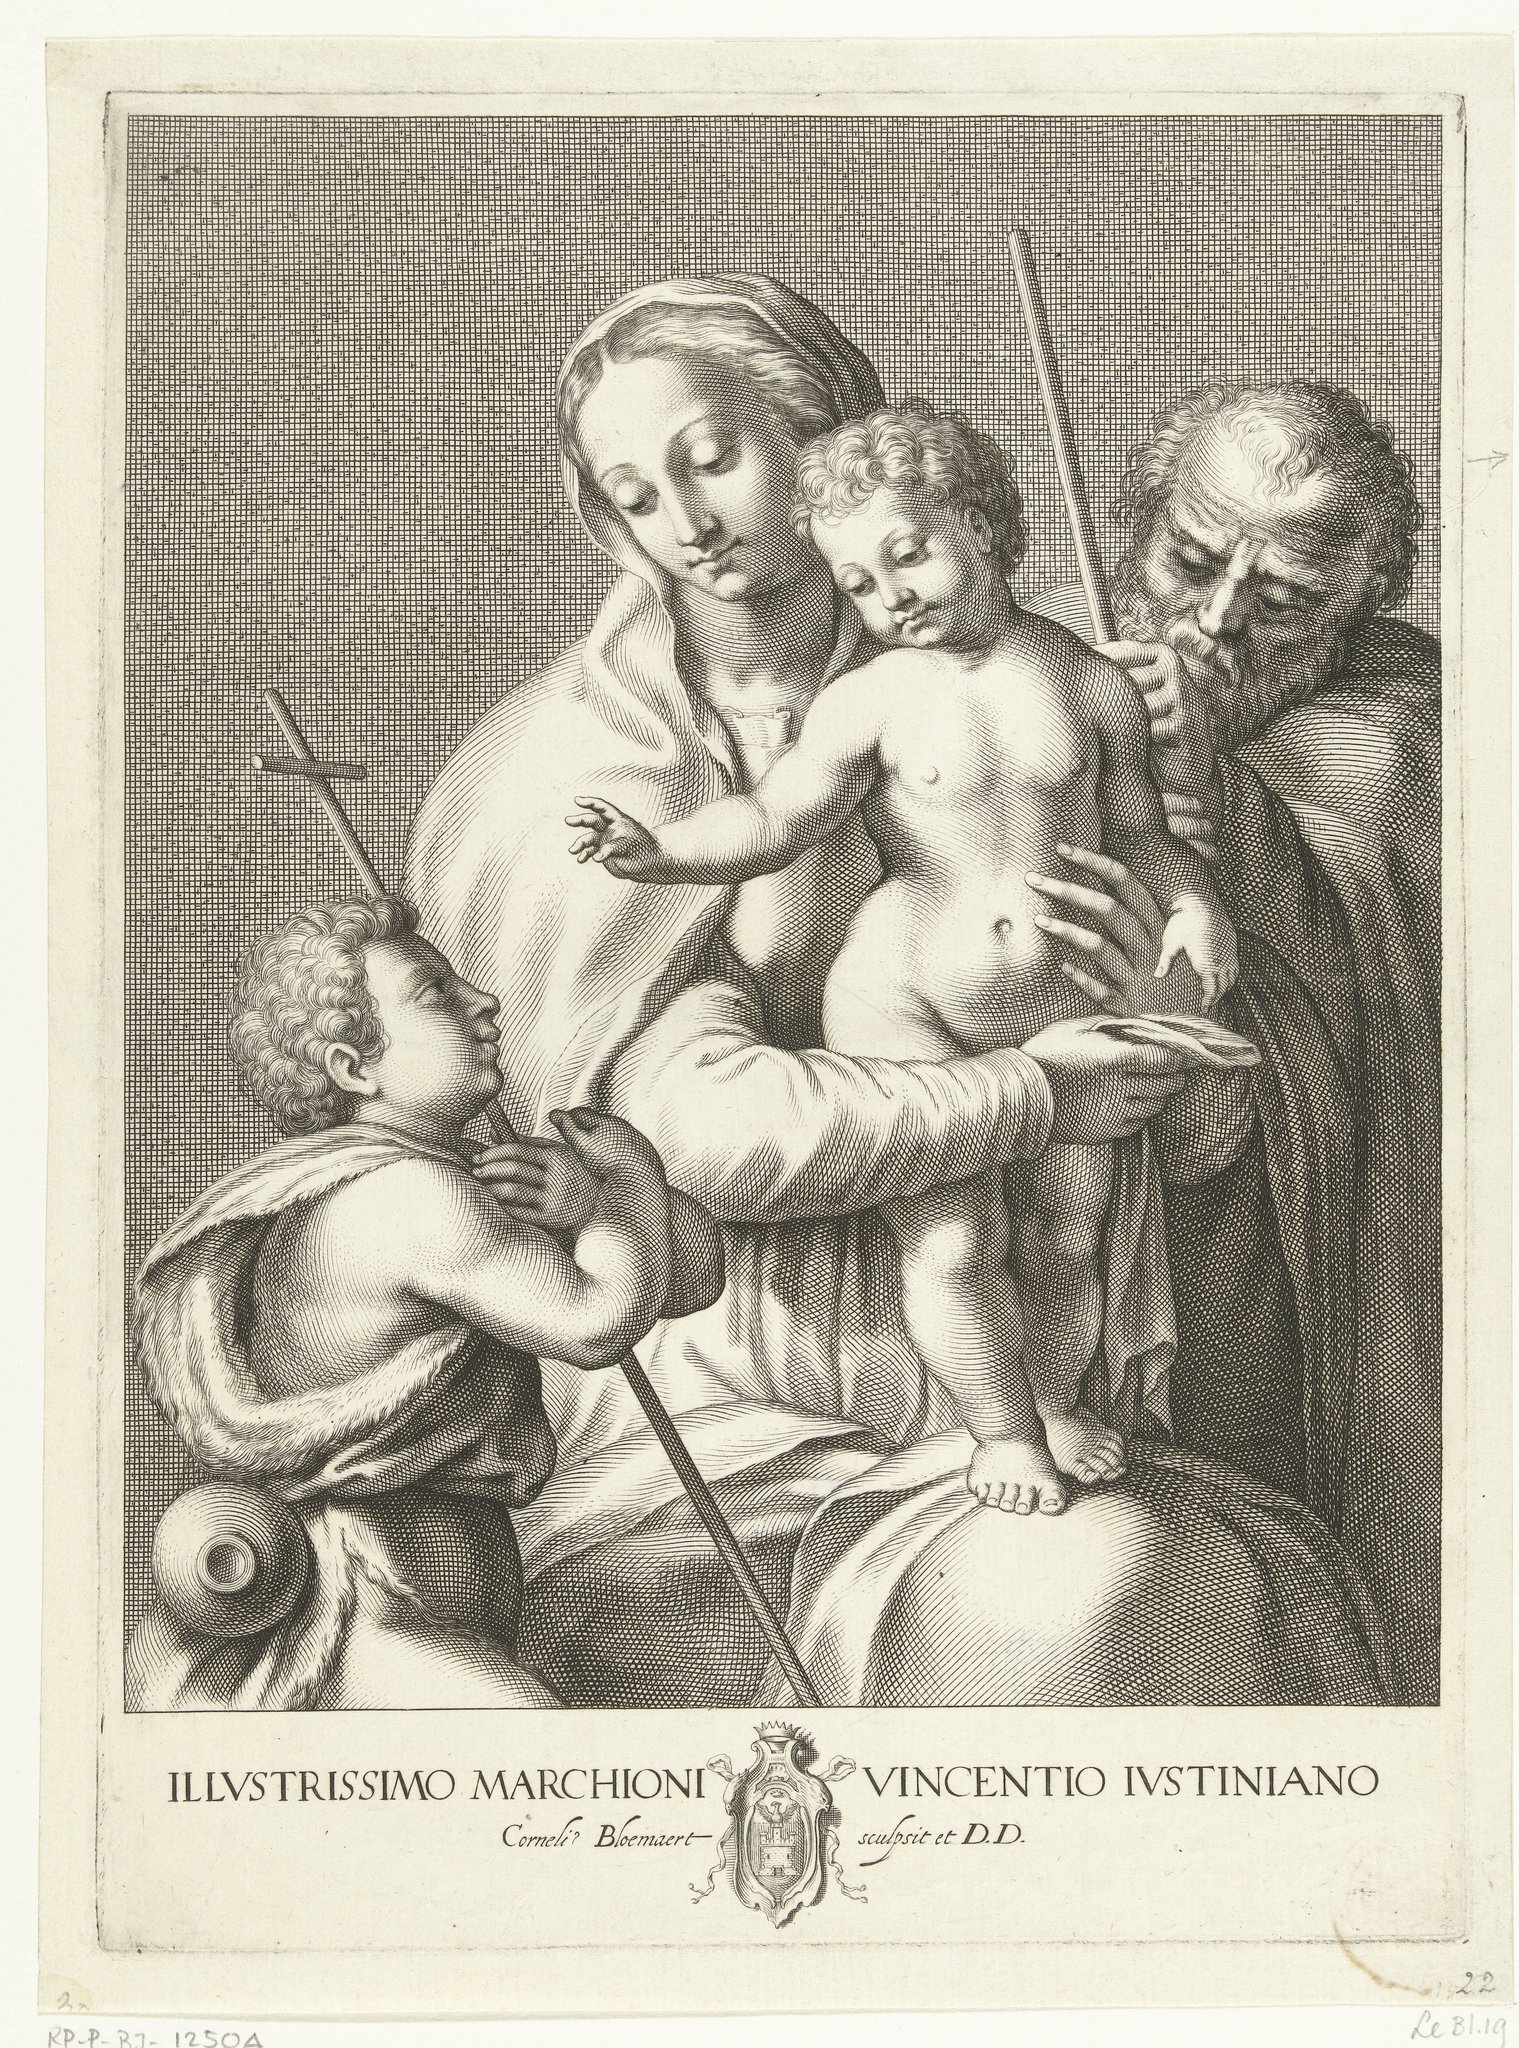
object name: print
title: Zittende Madonna en Johannes de Doper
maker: cornelis bloemaert (ii)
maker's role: draughtsman, print maker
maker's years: 1603-1692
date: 1633-1650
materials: paper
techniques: engraving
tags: madonna (i.e. mary with the christ-child) accompanied or surrounded by others, mary sitting or enthroned, the christ-child standing on her knee (christ-child to mary's left)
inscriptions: collector's mark: Lugt 240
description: Het Christuskind staat op de schoot van Maria. Achter hen staat Jozef. Op de voorgrond kijkt Johannes de Doper naar hen op.